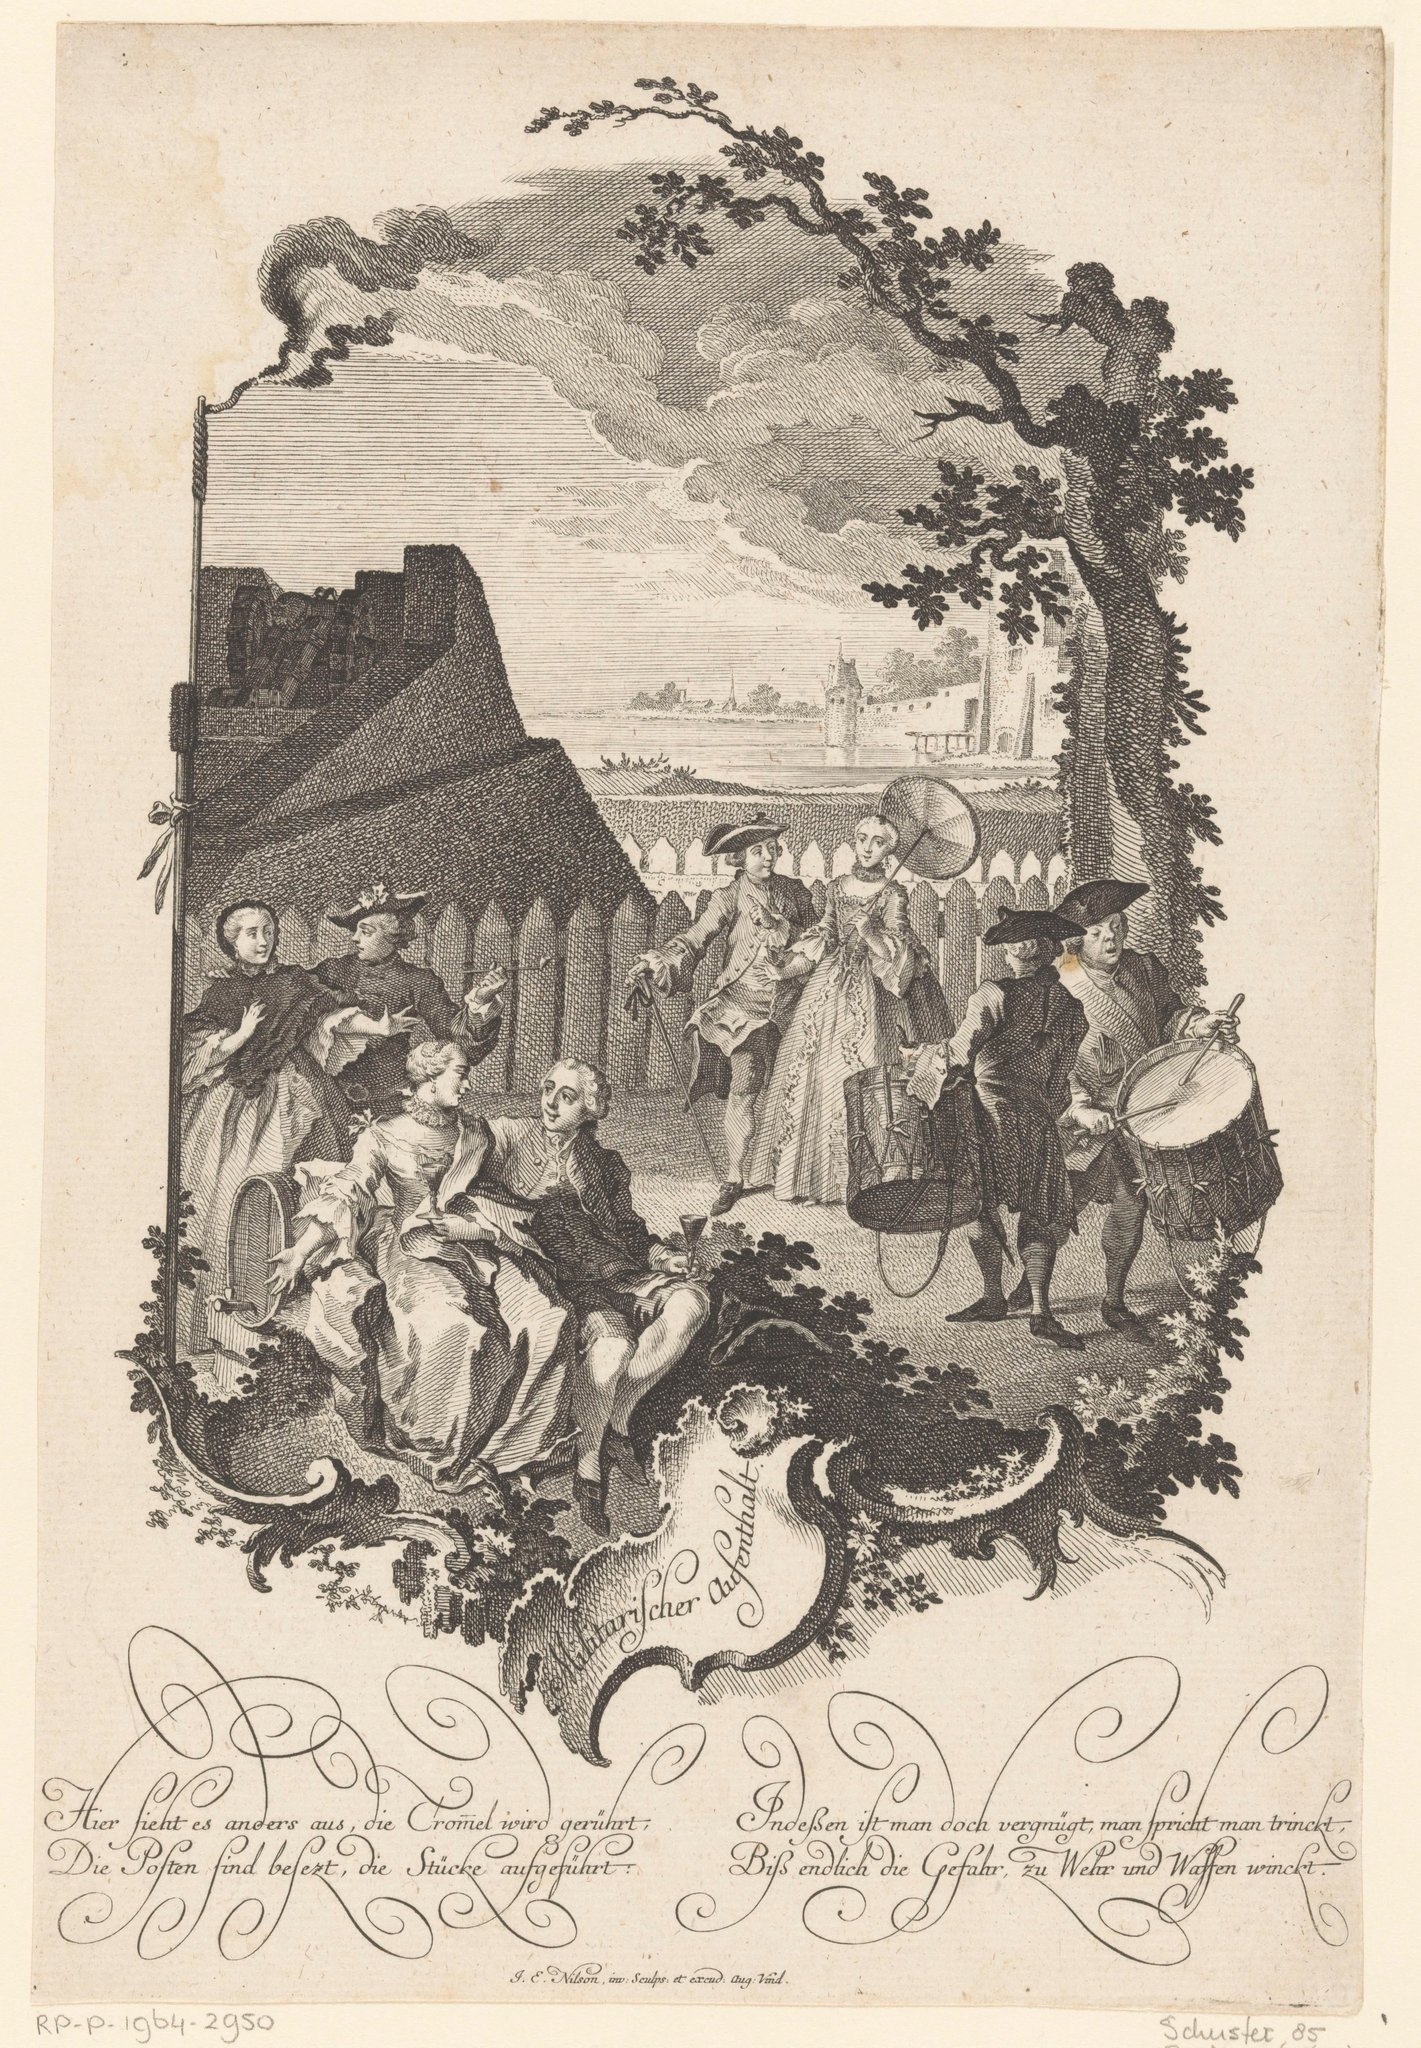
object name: ornament print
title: Militarischer Aufenthalt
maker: johann esaias nilson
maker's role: draughtsman, print maker, publisher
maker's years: 1721-1788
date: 1731-1788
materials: paper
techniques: engraving, etching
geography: augsburg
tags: the soldier; the soldier's life, resting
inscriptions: collector's mark: Lugt 2228, collector's mark: Lugt 2760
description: Drie militairen genieten in het bijzijn van drie vrouwen van hun rust. Zij roken, drinken en wandelen. Rechts staan twee trommelaars. In de achtergrond een verdedigingswerk met kanon en een doorkijk naar een ommuring aan het water. Aan de onderzijde van de voorstelling een rocaille omlijsting. In de ondermarge twee kolommen met tweeregelige Duitse tekst.